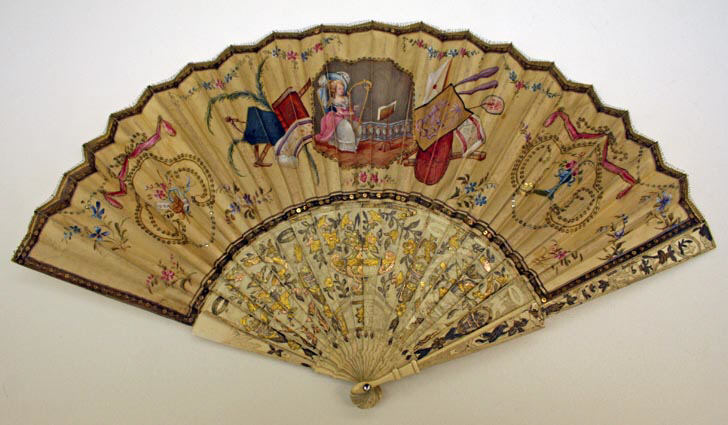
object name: fan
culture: french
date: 1774-1789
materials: gold, ivory, silk, silver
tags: women,musicians